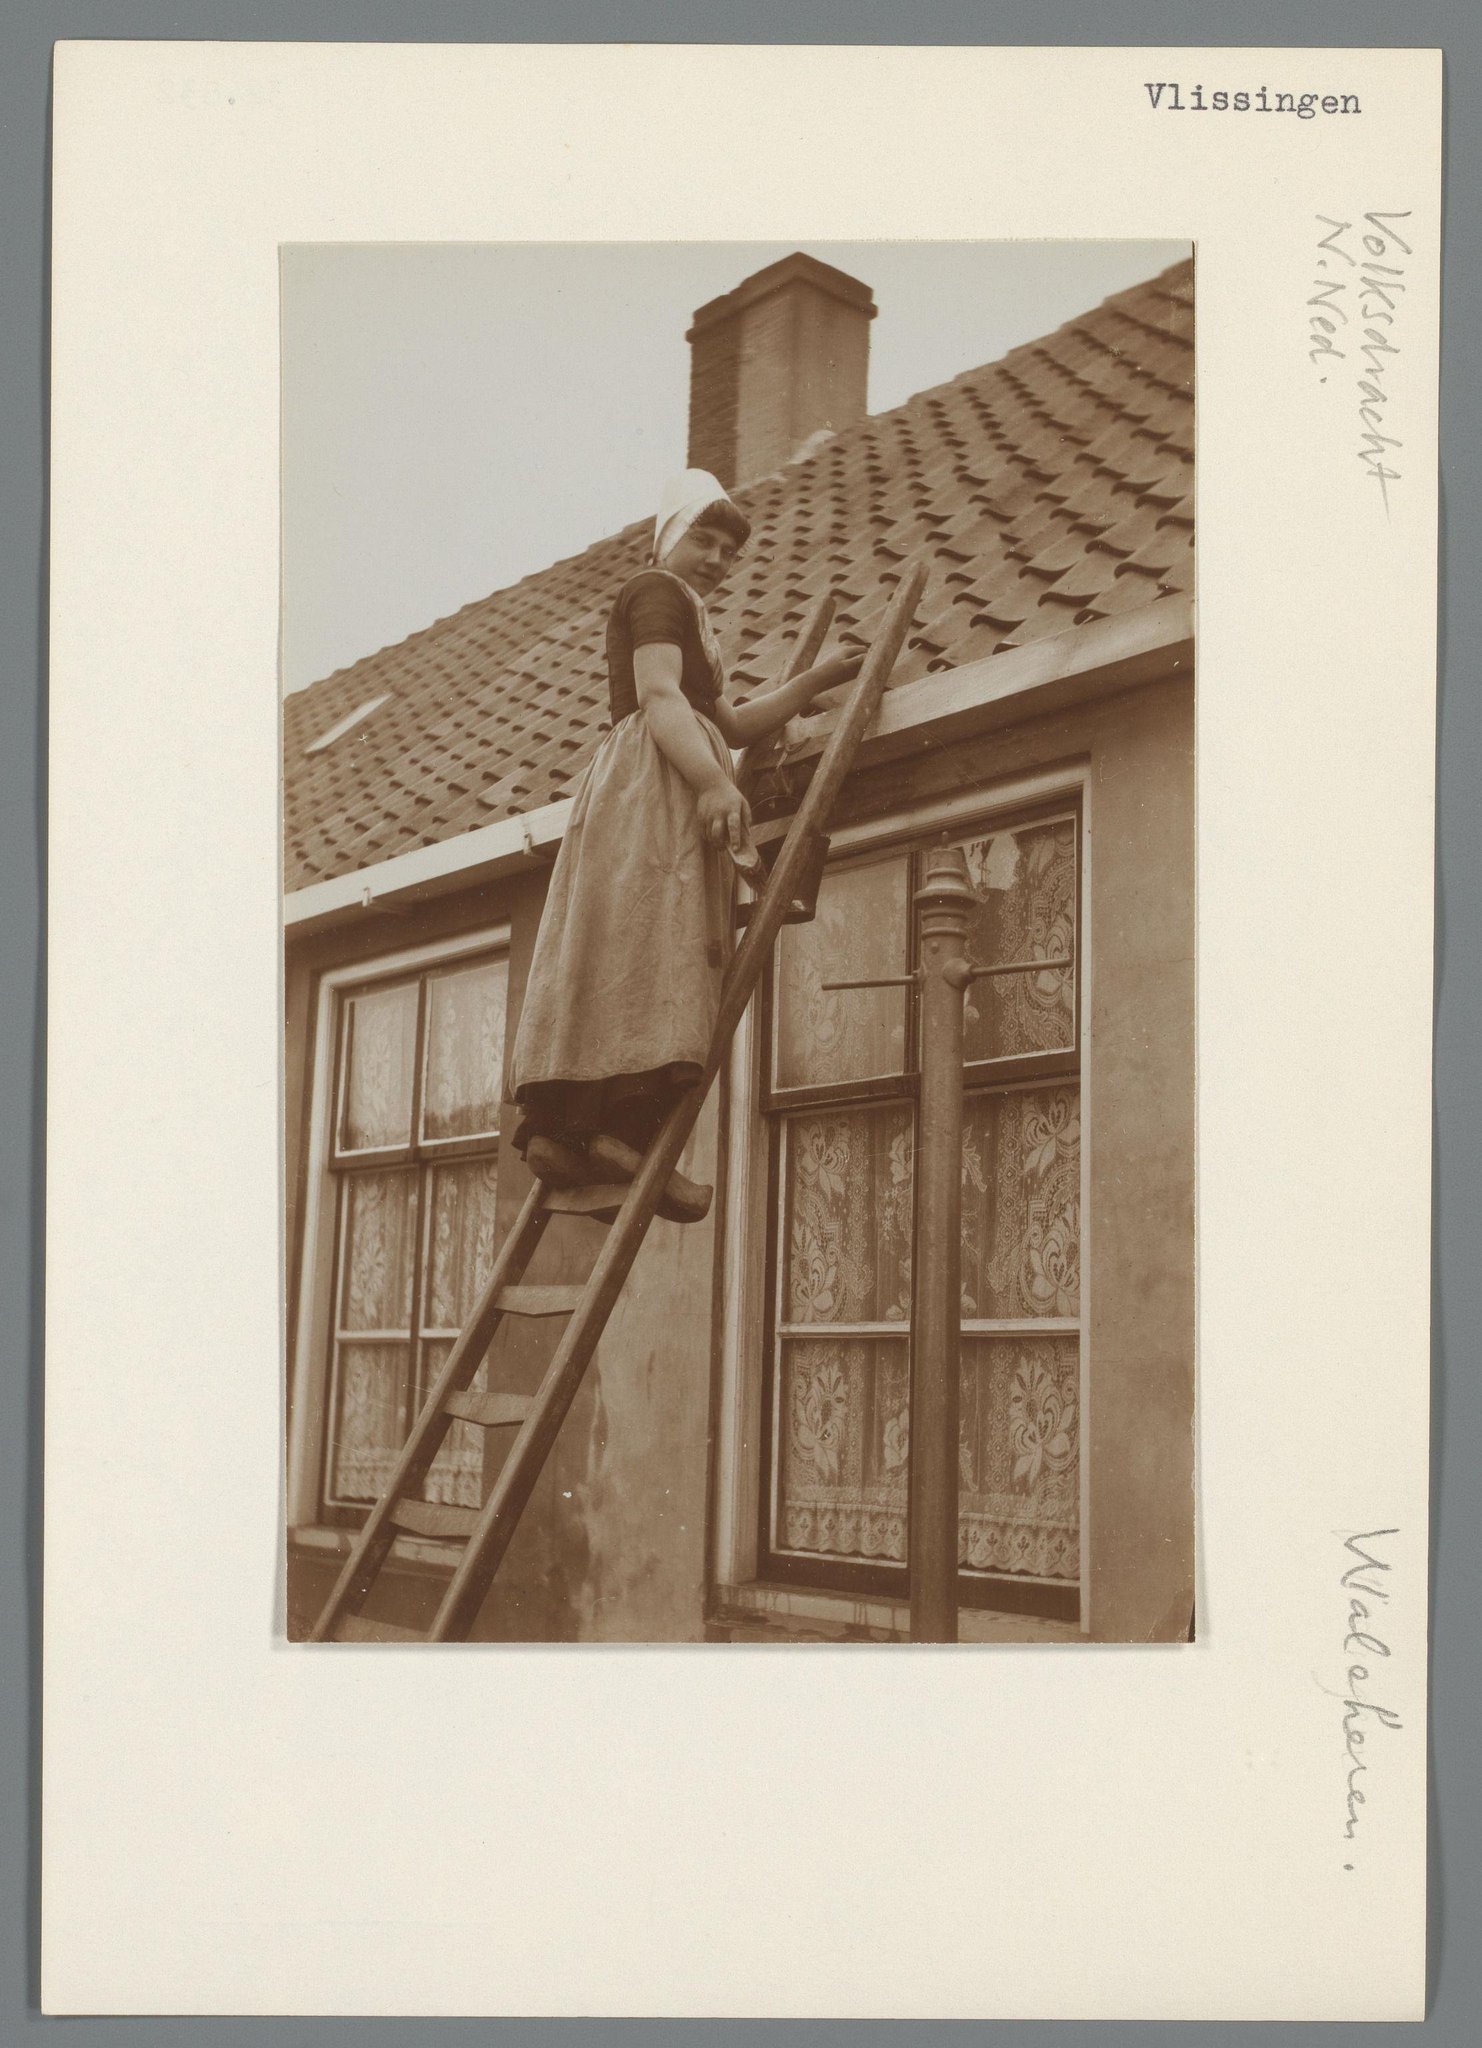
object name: photograph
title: Vlissingen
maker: Anonymous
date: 1880-1920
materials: paper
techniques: collodion silver print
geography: walcheren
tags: historical persons, folk costume, regional costume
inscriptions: number: ‘32.832’, number: ‘- 527078’, inscription: ‘(andersom afgedrukt!)’, inscription: ‘Volksdracht/ N.Ned./ Walcheren’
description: De vrouw staat op een ladder die tegen een dakgoot leunt.